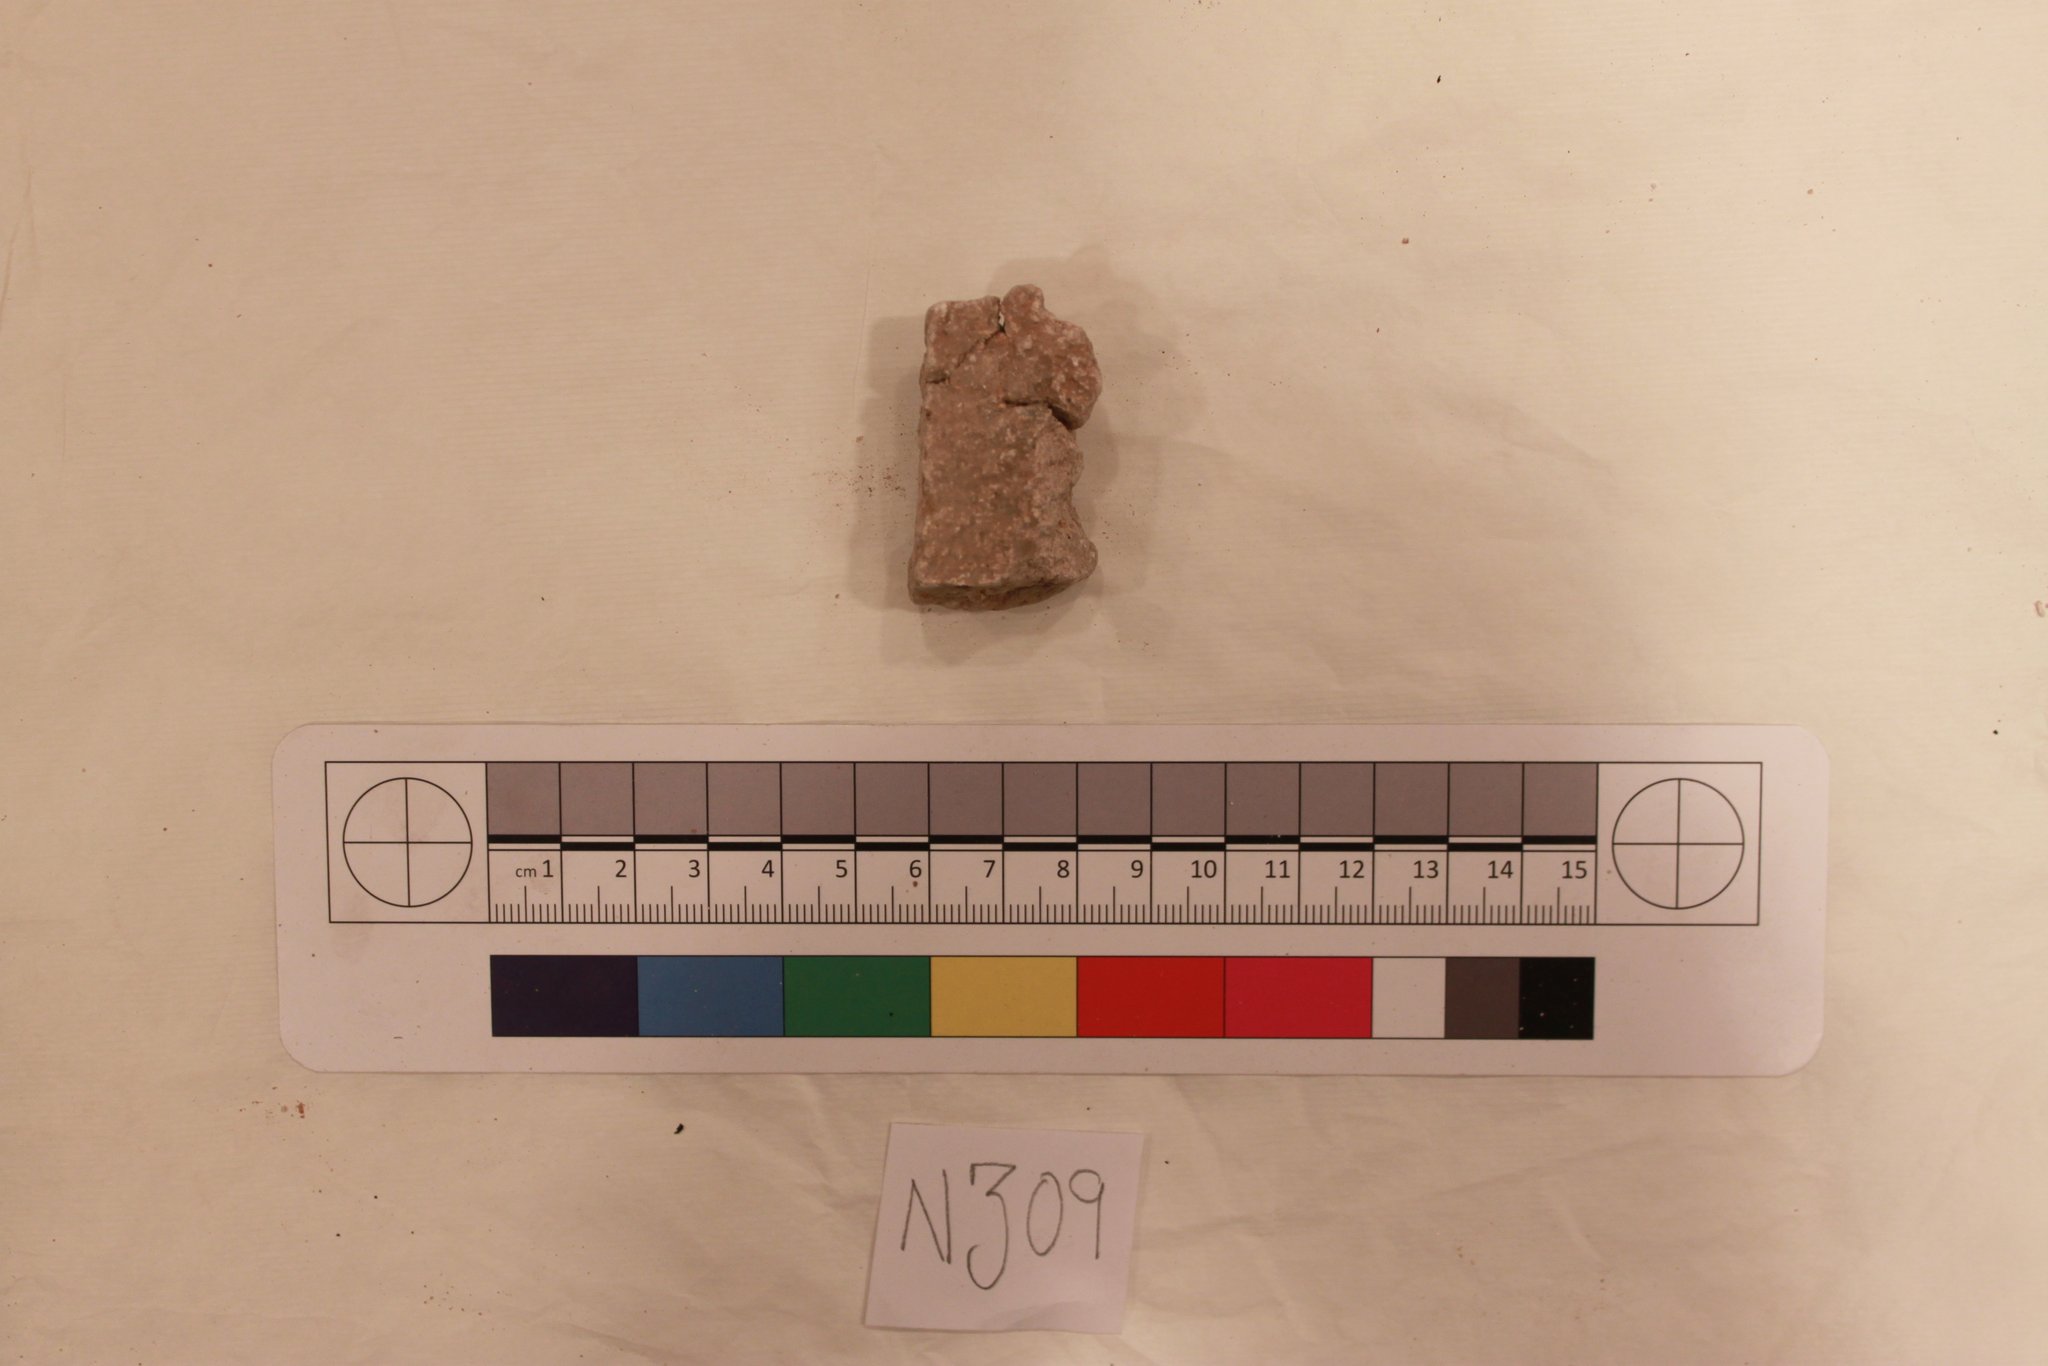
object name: fragment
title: Stucco Fragment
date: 701-1200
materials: plaster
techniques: carving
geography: iran